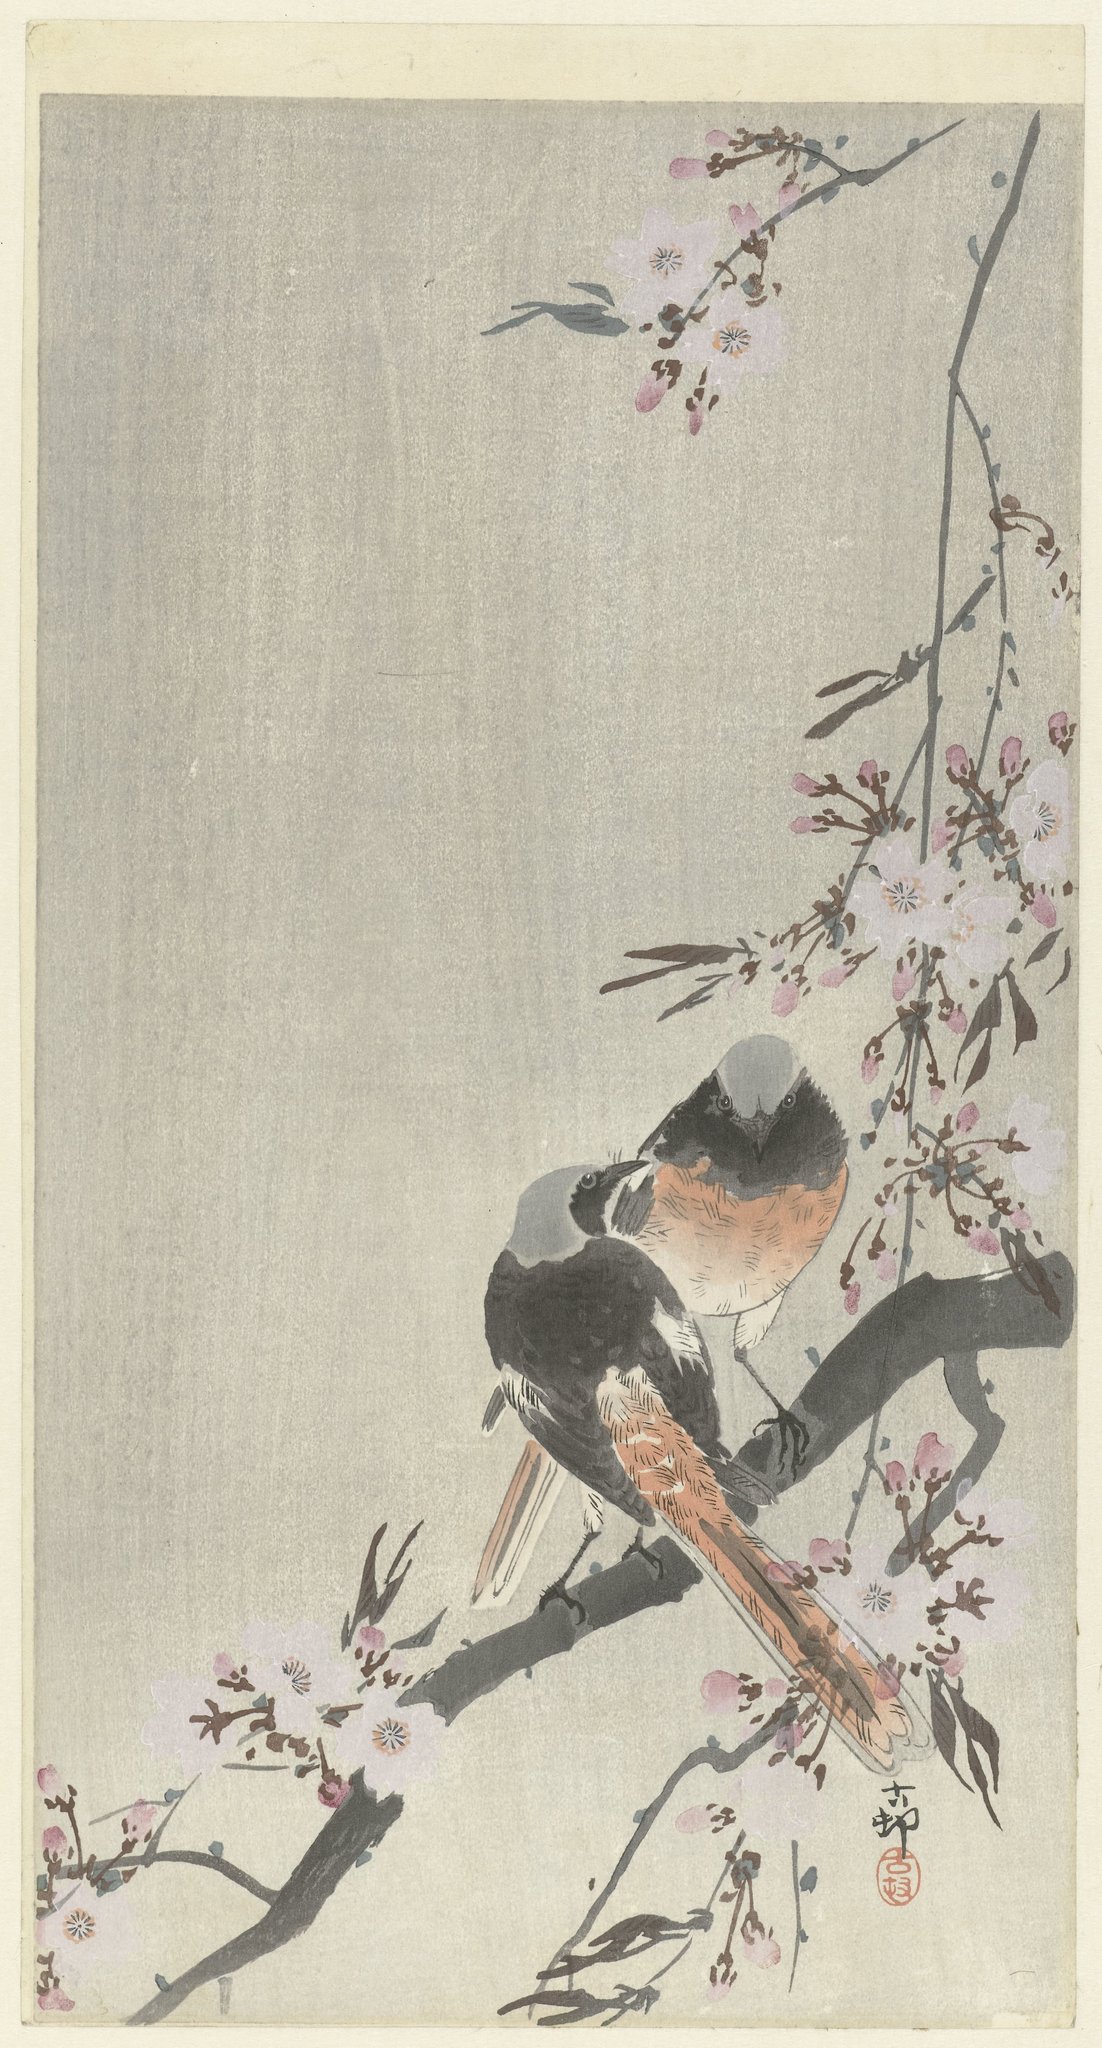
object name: print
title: Twee siegelroodstaarten met kersenbloesem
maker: ohara koson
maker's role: print maker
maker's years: 1877-1945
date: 1900-1936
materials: paper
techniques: woodcut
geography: japan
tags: plants; vegetation, birds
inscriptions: collector's mark: Lugt 2228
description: Twee zwart-rode vogels op tak met bloeiende kersenbloesem.